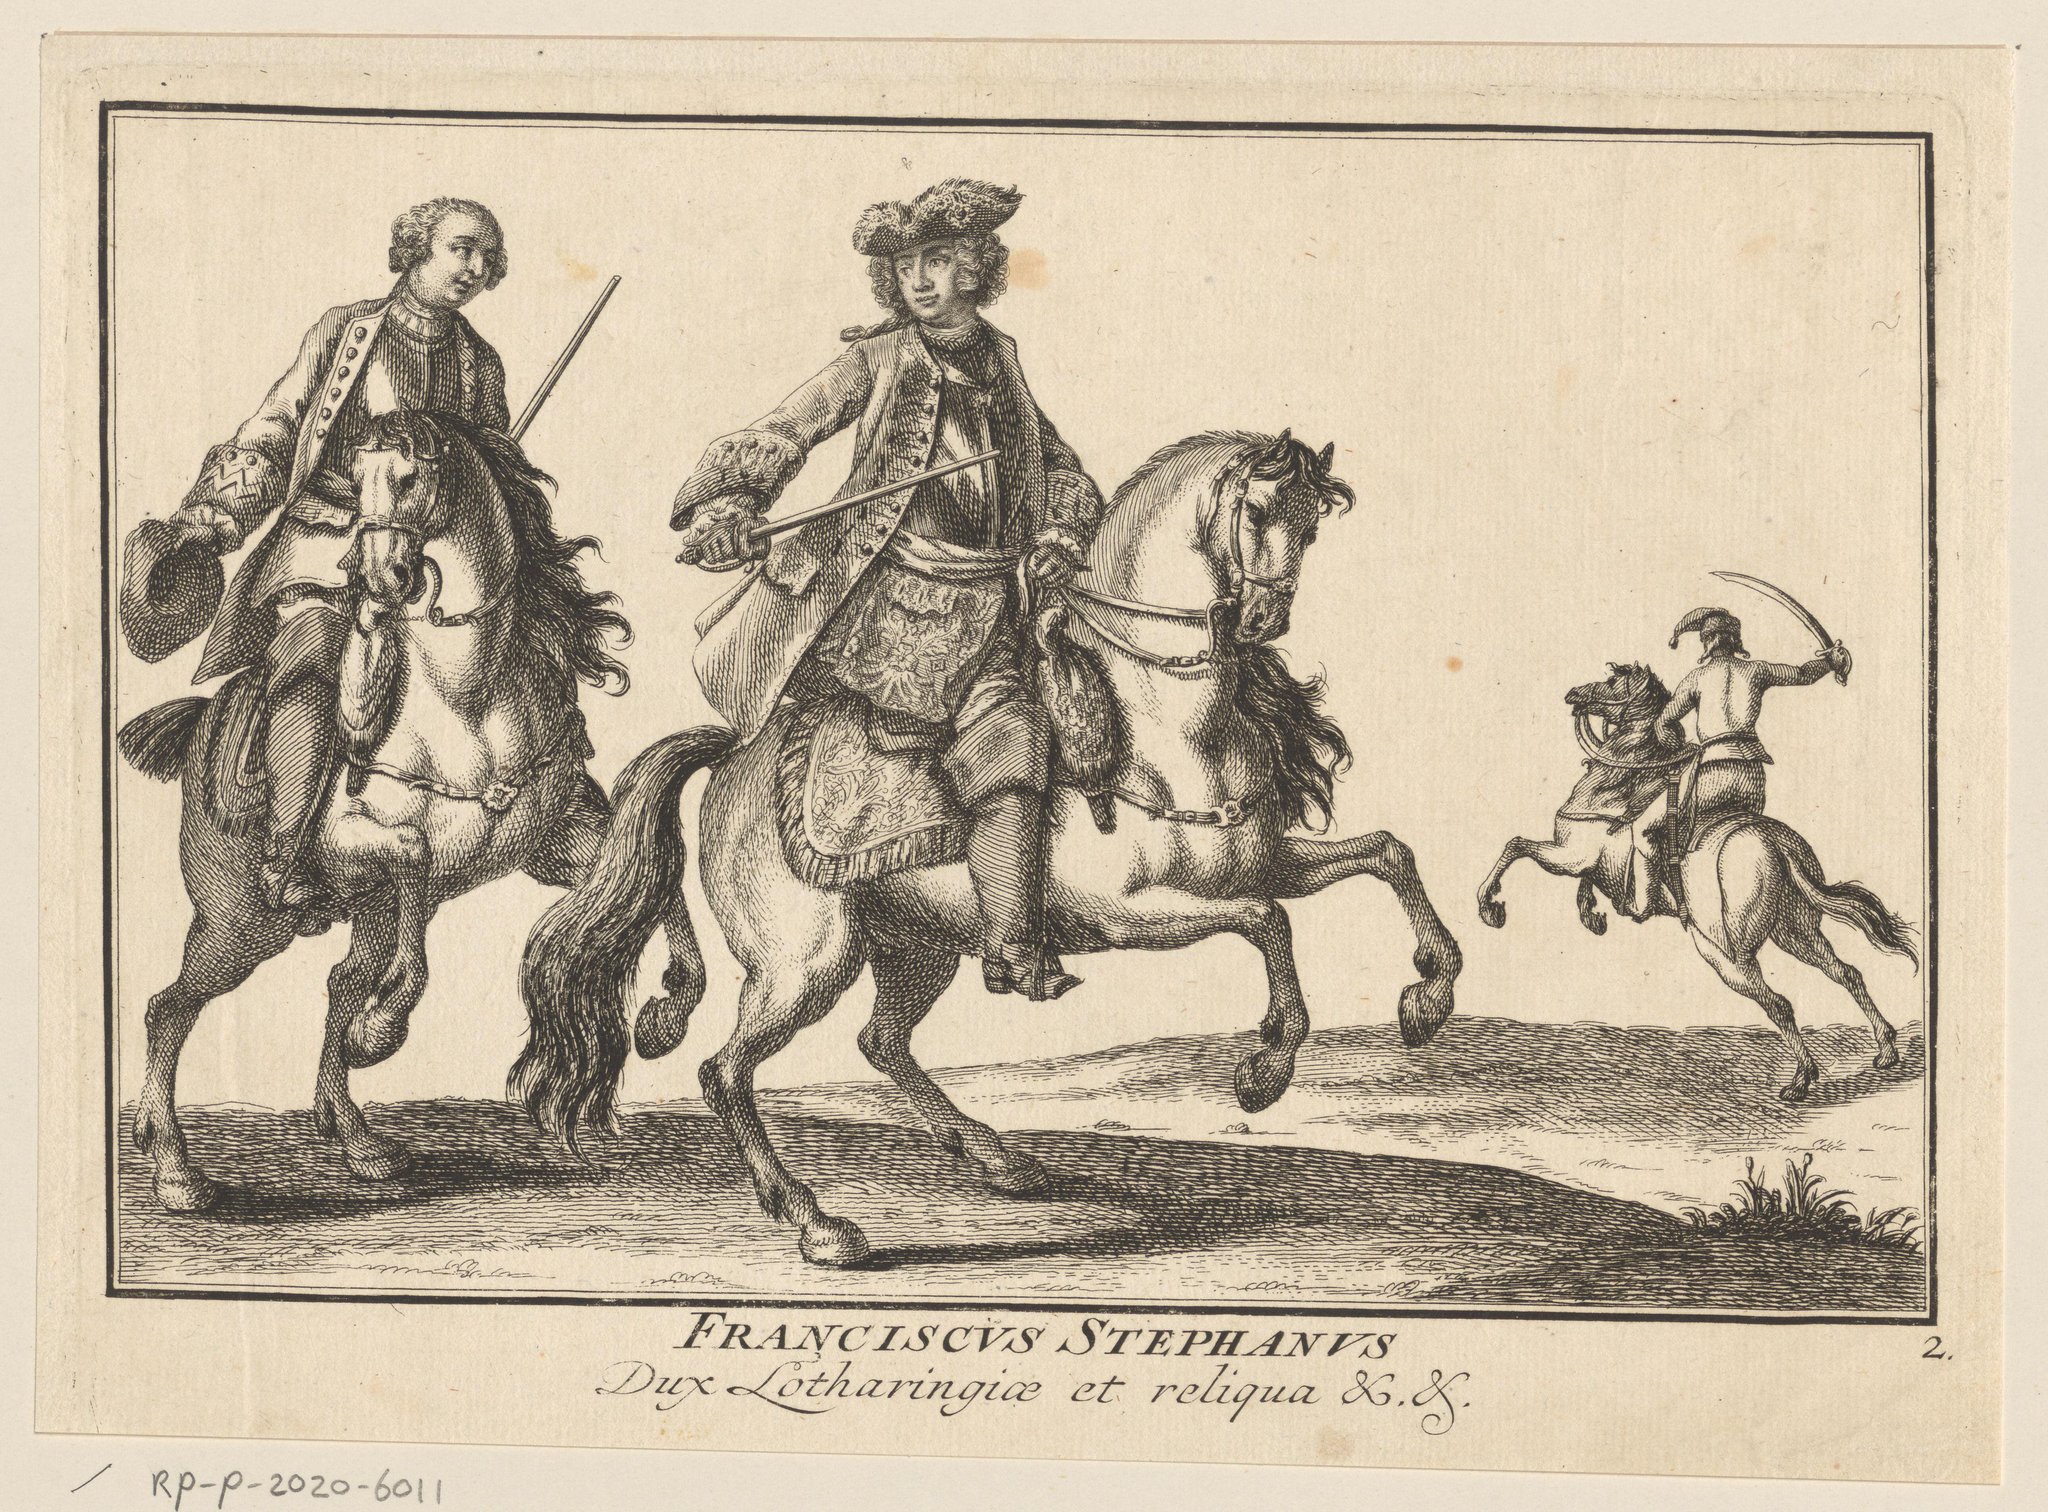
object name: print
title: Ruiterportret van keizer Frans I Stefan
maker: Anonymous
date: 1729-1750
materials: paper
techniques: engraving, etching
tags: frans i stefan (duits keizer), riding a horse, ass, or mule; rider, horseman, historical persons, hacking and thrusting weapons: sword, emperor